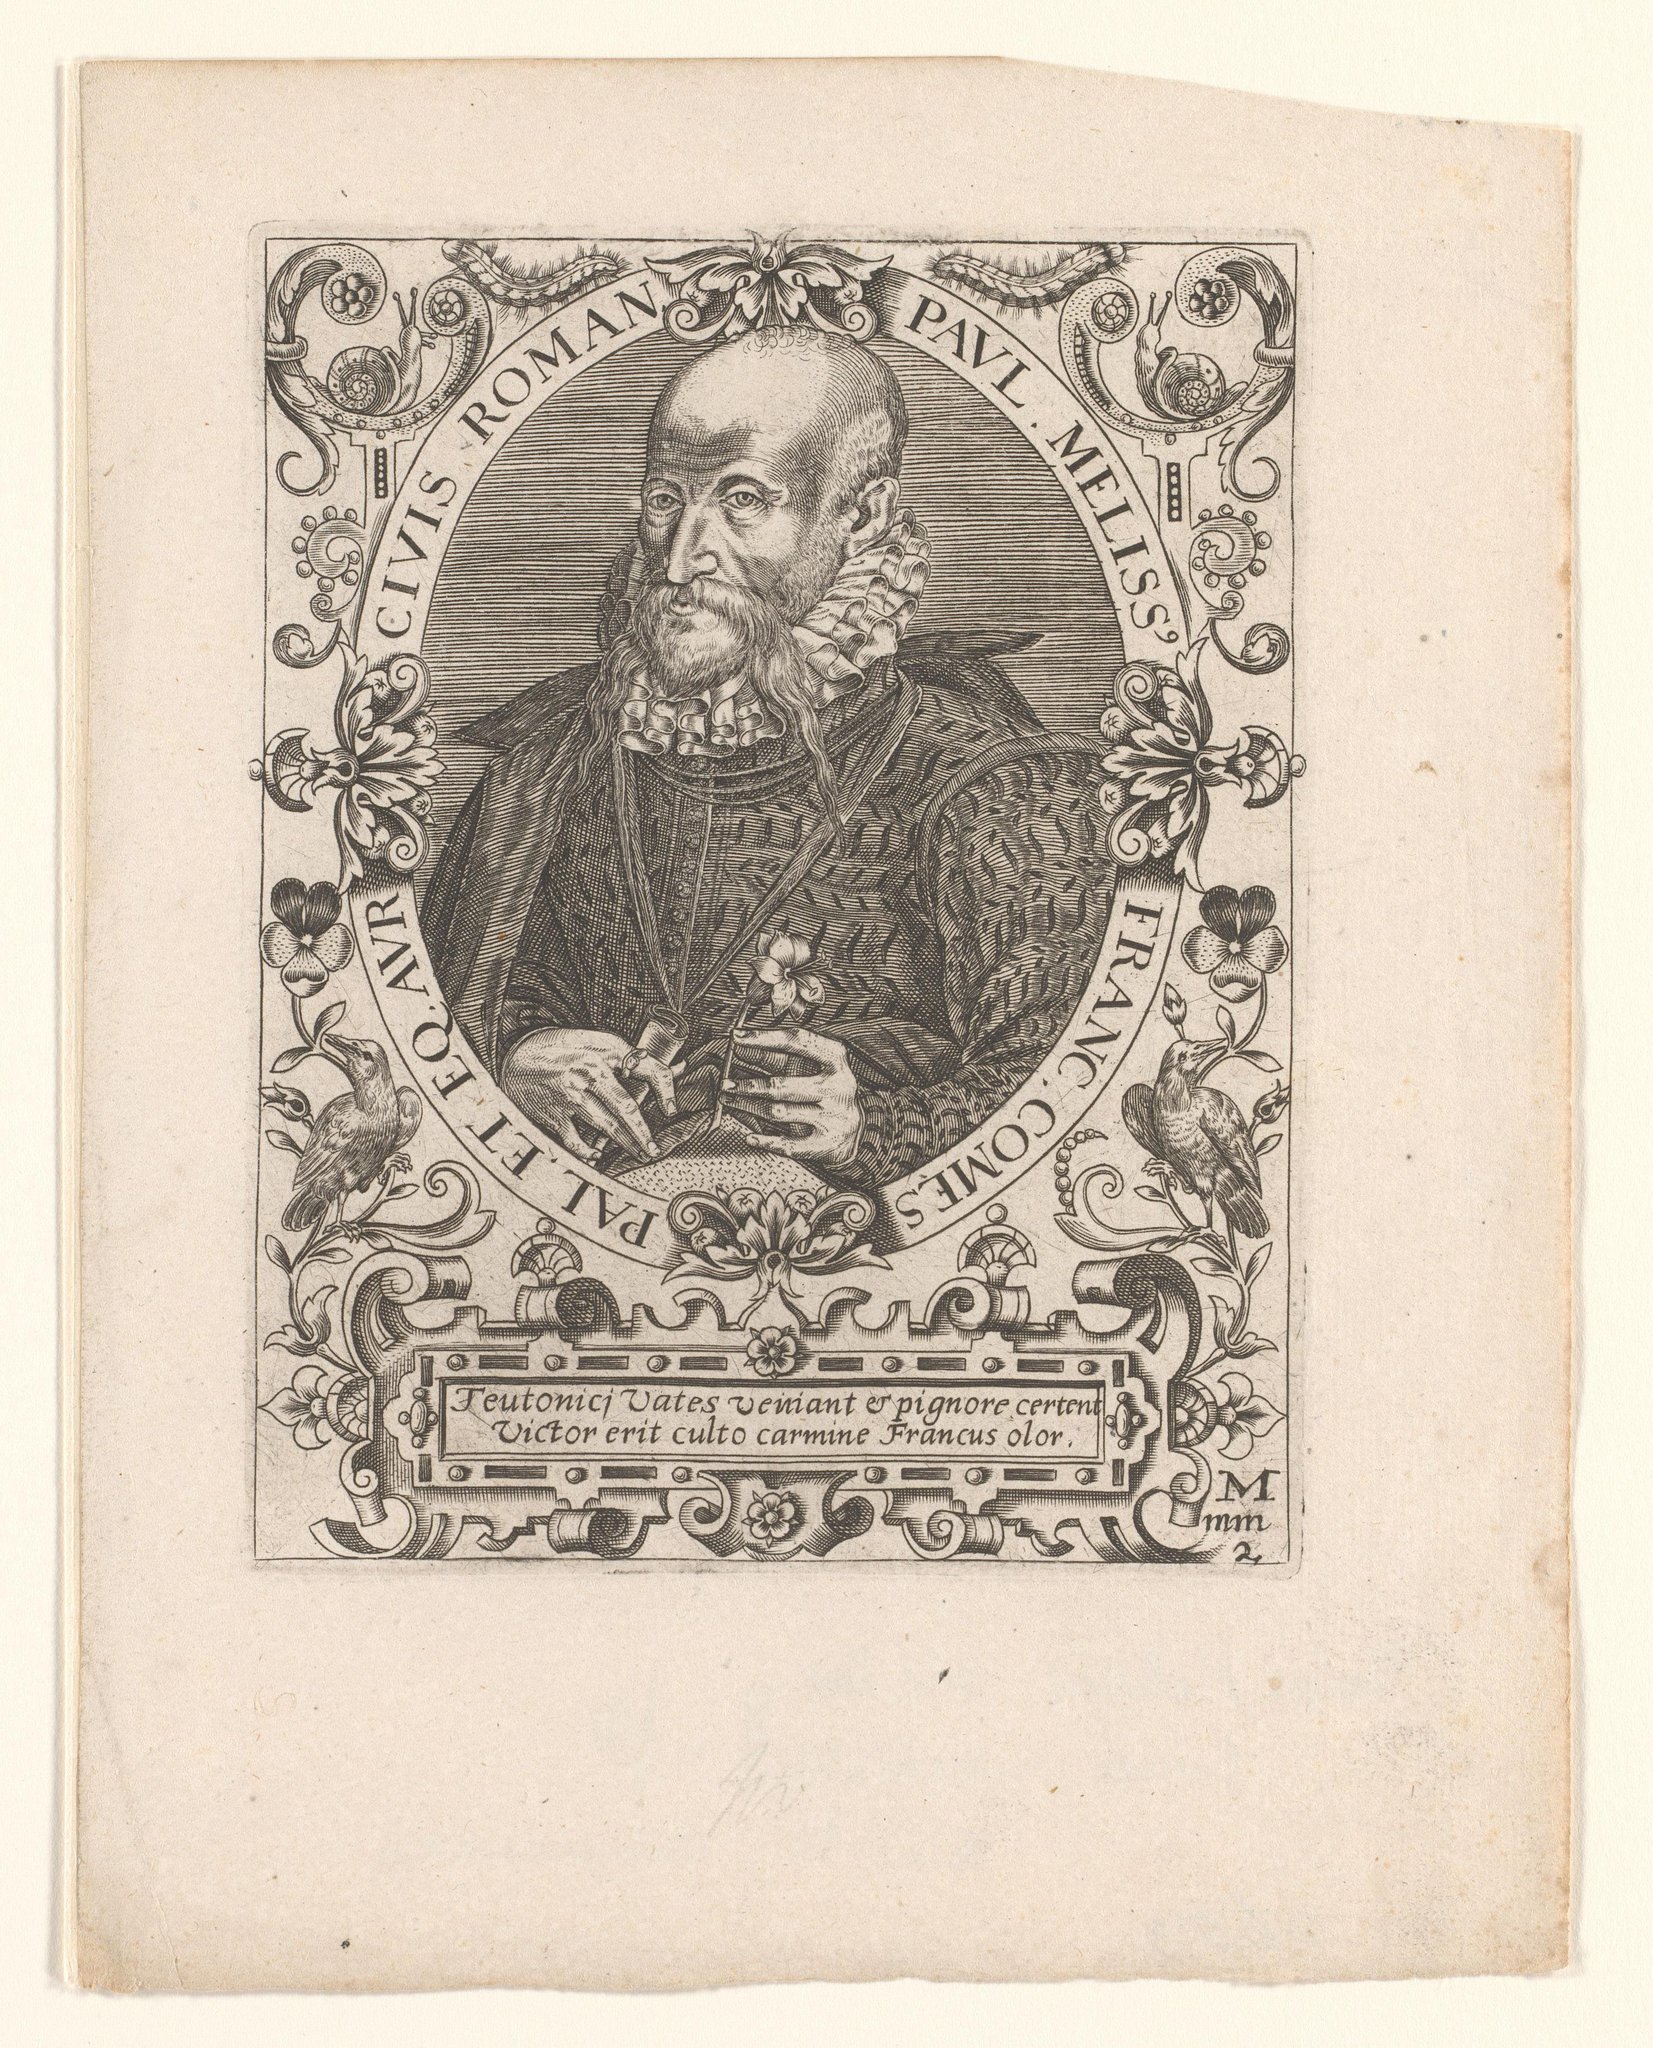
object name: print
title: Paul. Meliss[9] Franc comes pal. et eq. aur civis Roman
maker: jean jacques boissard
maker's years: 1528-1598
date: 1650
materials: paper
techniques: engraving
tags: paul schede, historical persons, writer, poet, author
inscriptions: collector's mark: Lugt 2228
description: Prent gebruikt in: Boissard, Jean Jacques. Bibliotheca chalcographica. 8 dln. Frankfurt am Main: Johannes Ammon, 1650-1652. Ook gebruikt in latere edities. Eerdere staat van prent verschenen in: Boissard, Jean Jacques. Icones quinquaginta virorum illustrium doctrina & eruditione praestantium ad vivum effictae. 4 dln. Frankfurt am Main: s.n., 1597-1599. Mogelijk ook gebruikt in latere edities.